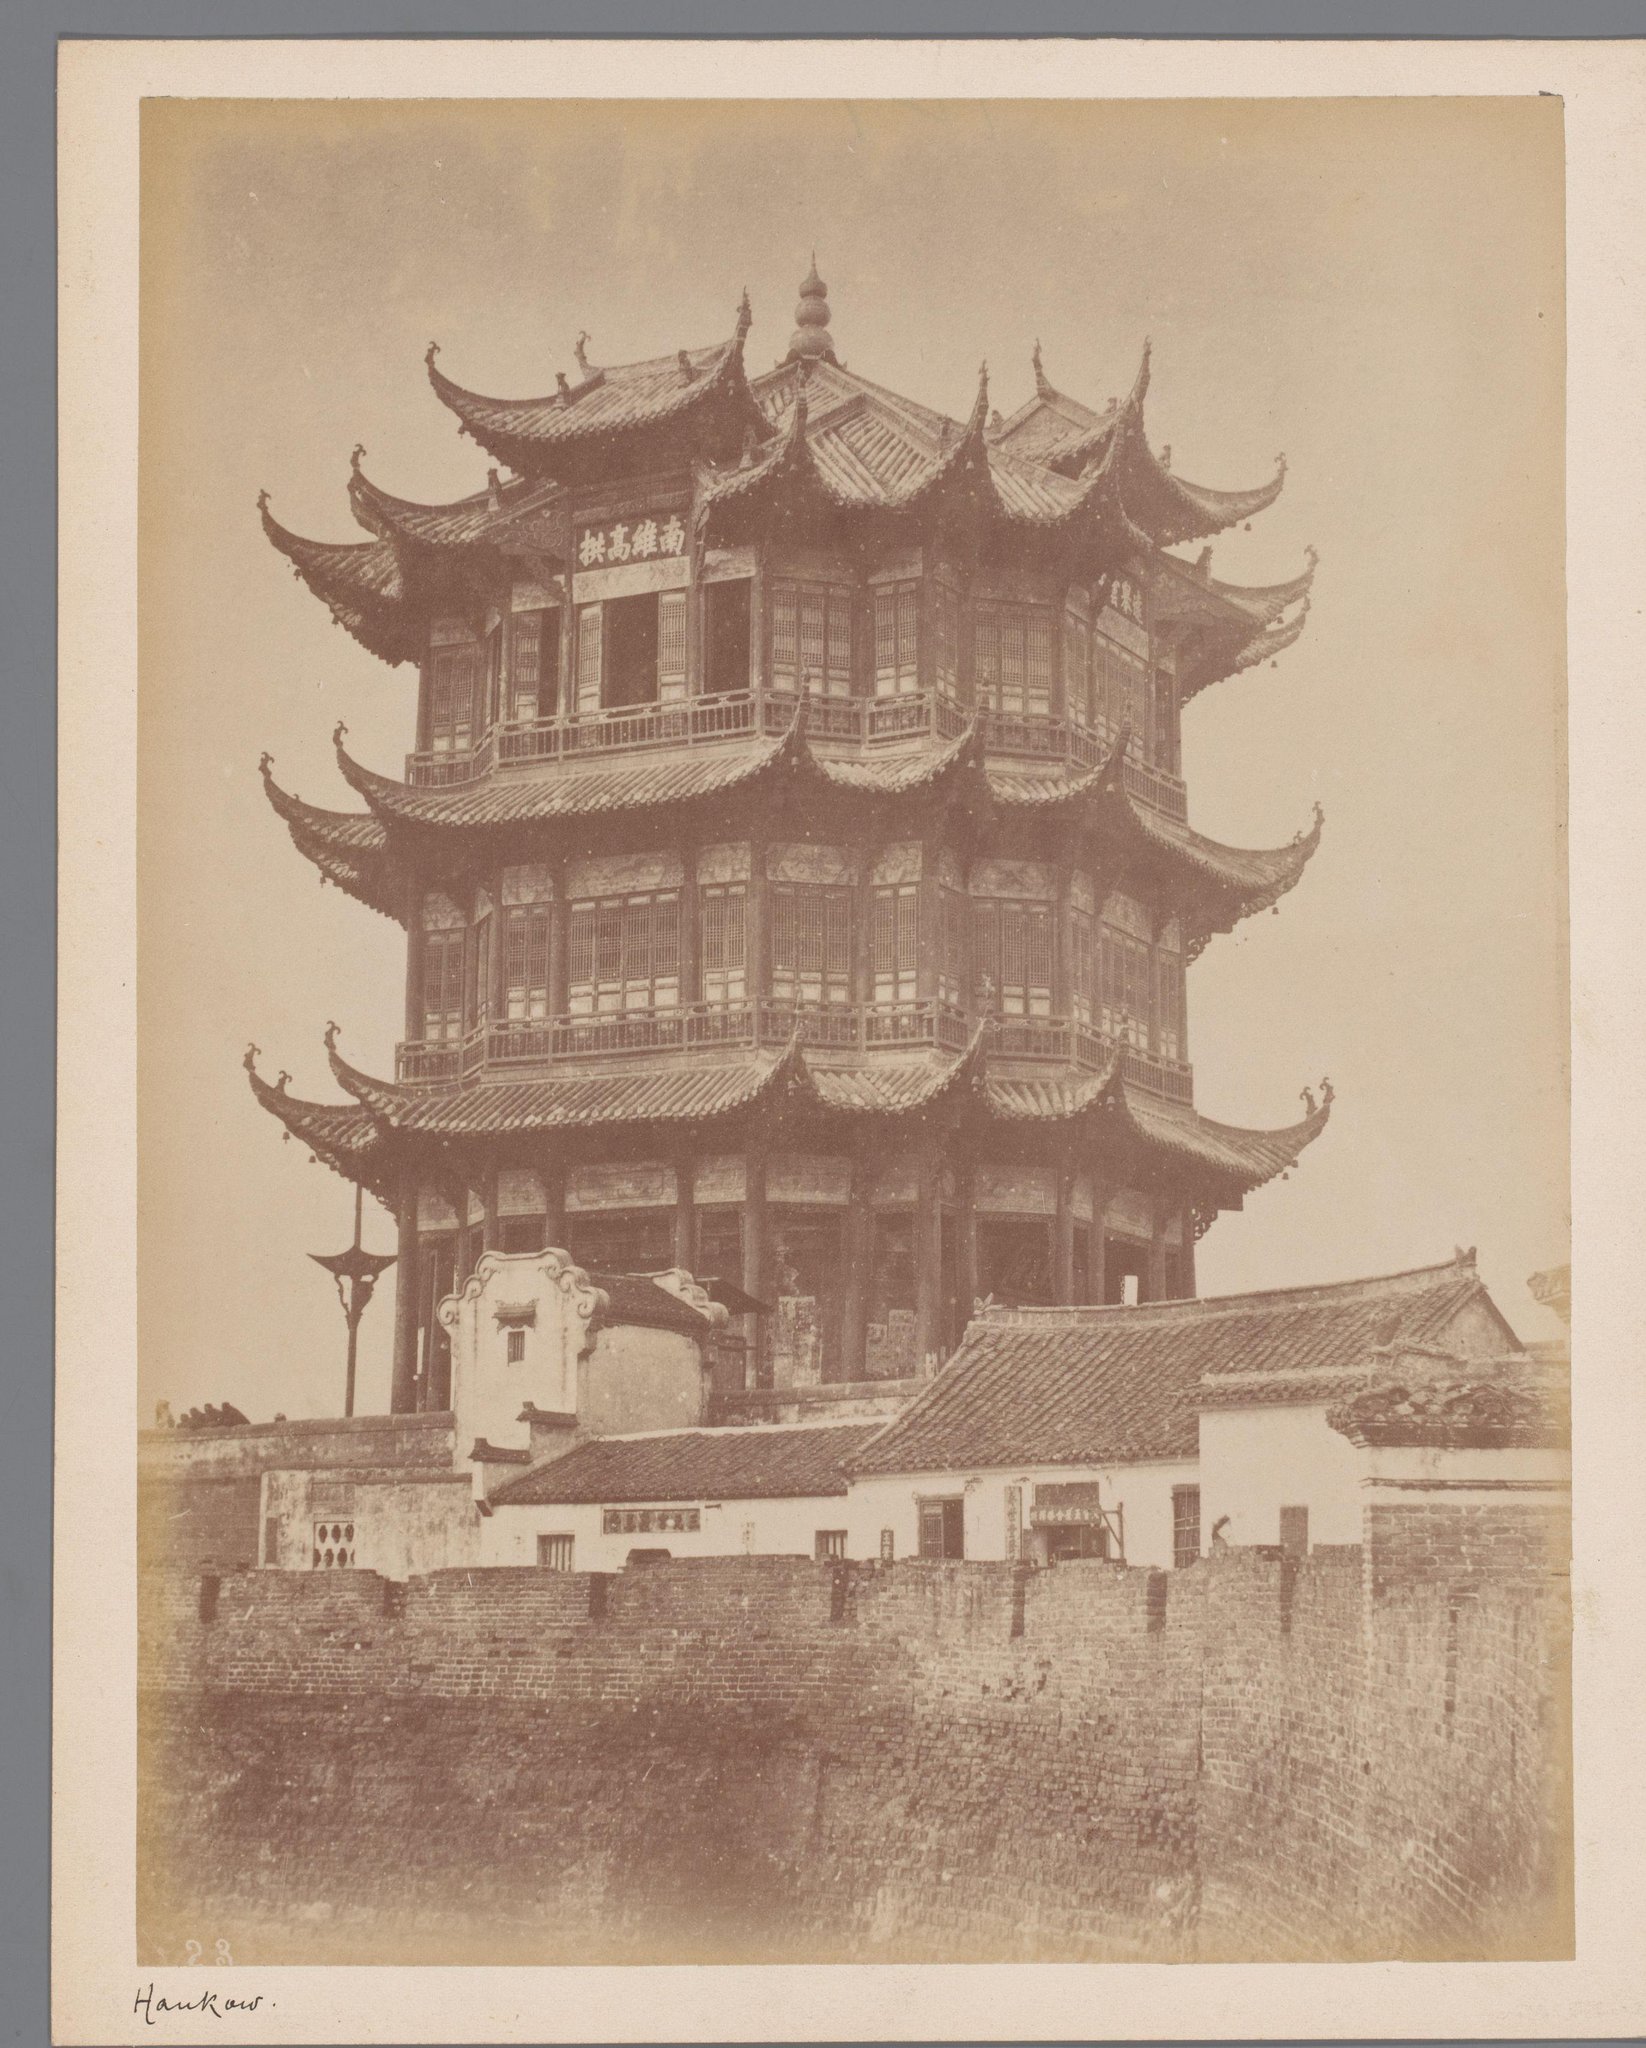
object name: photograph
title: Gezicht op de voormalige Yellow Crane Tower te Wuhan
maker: Anonymous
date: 1868-1884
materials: cardboard, photographic support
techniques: albumen print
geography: hankou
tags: temple, shrine ~ traditional chinese religions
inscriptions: annotation: ‘Hankou’